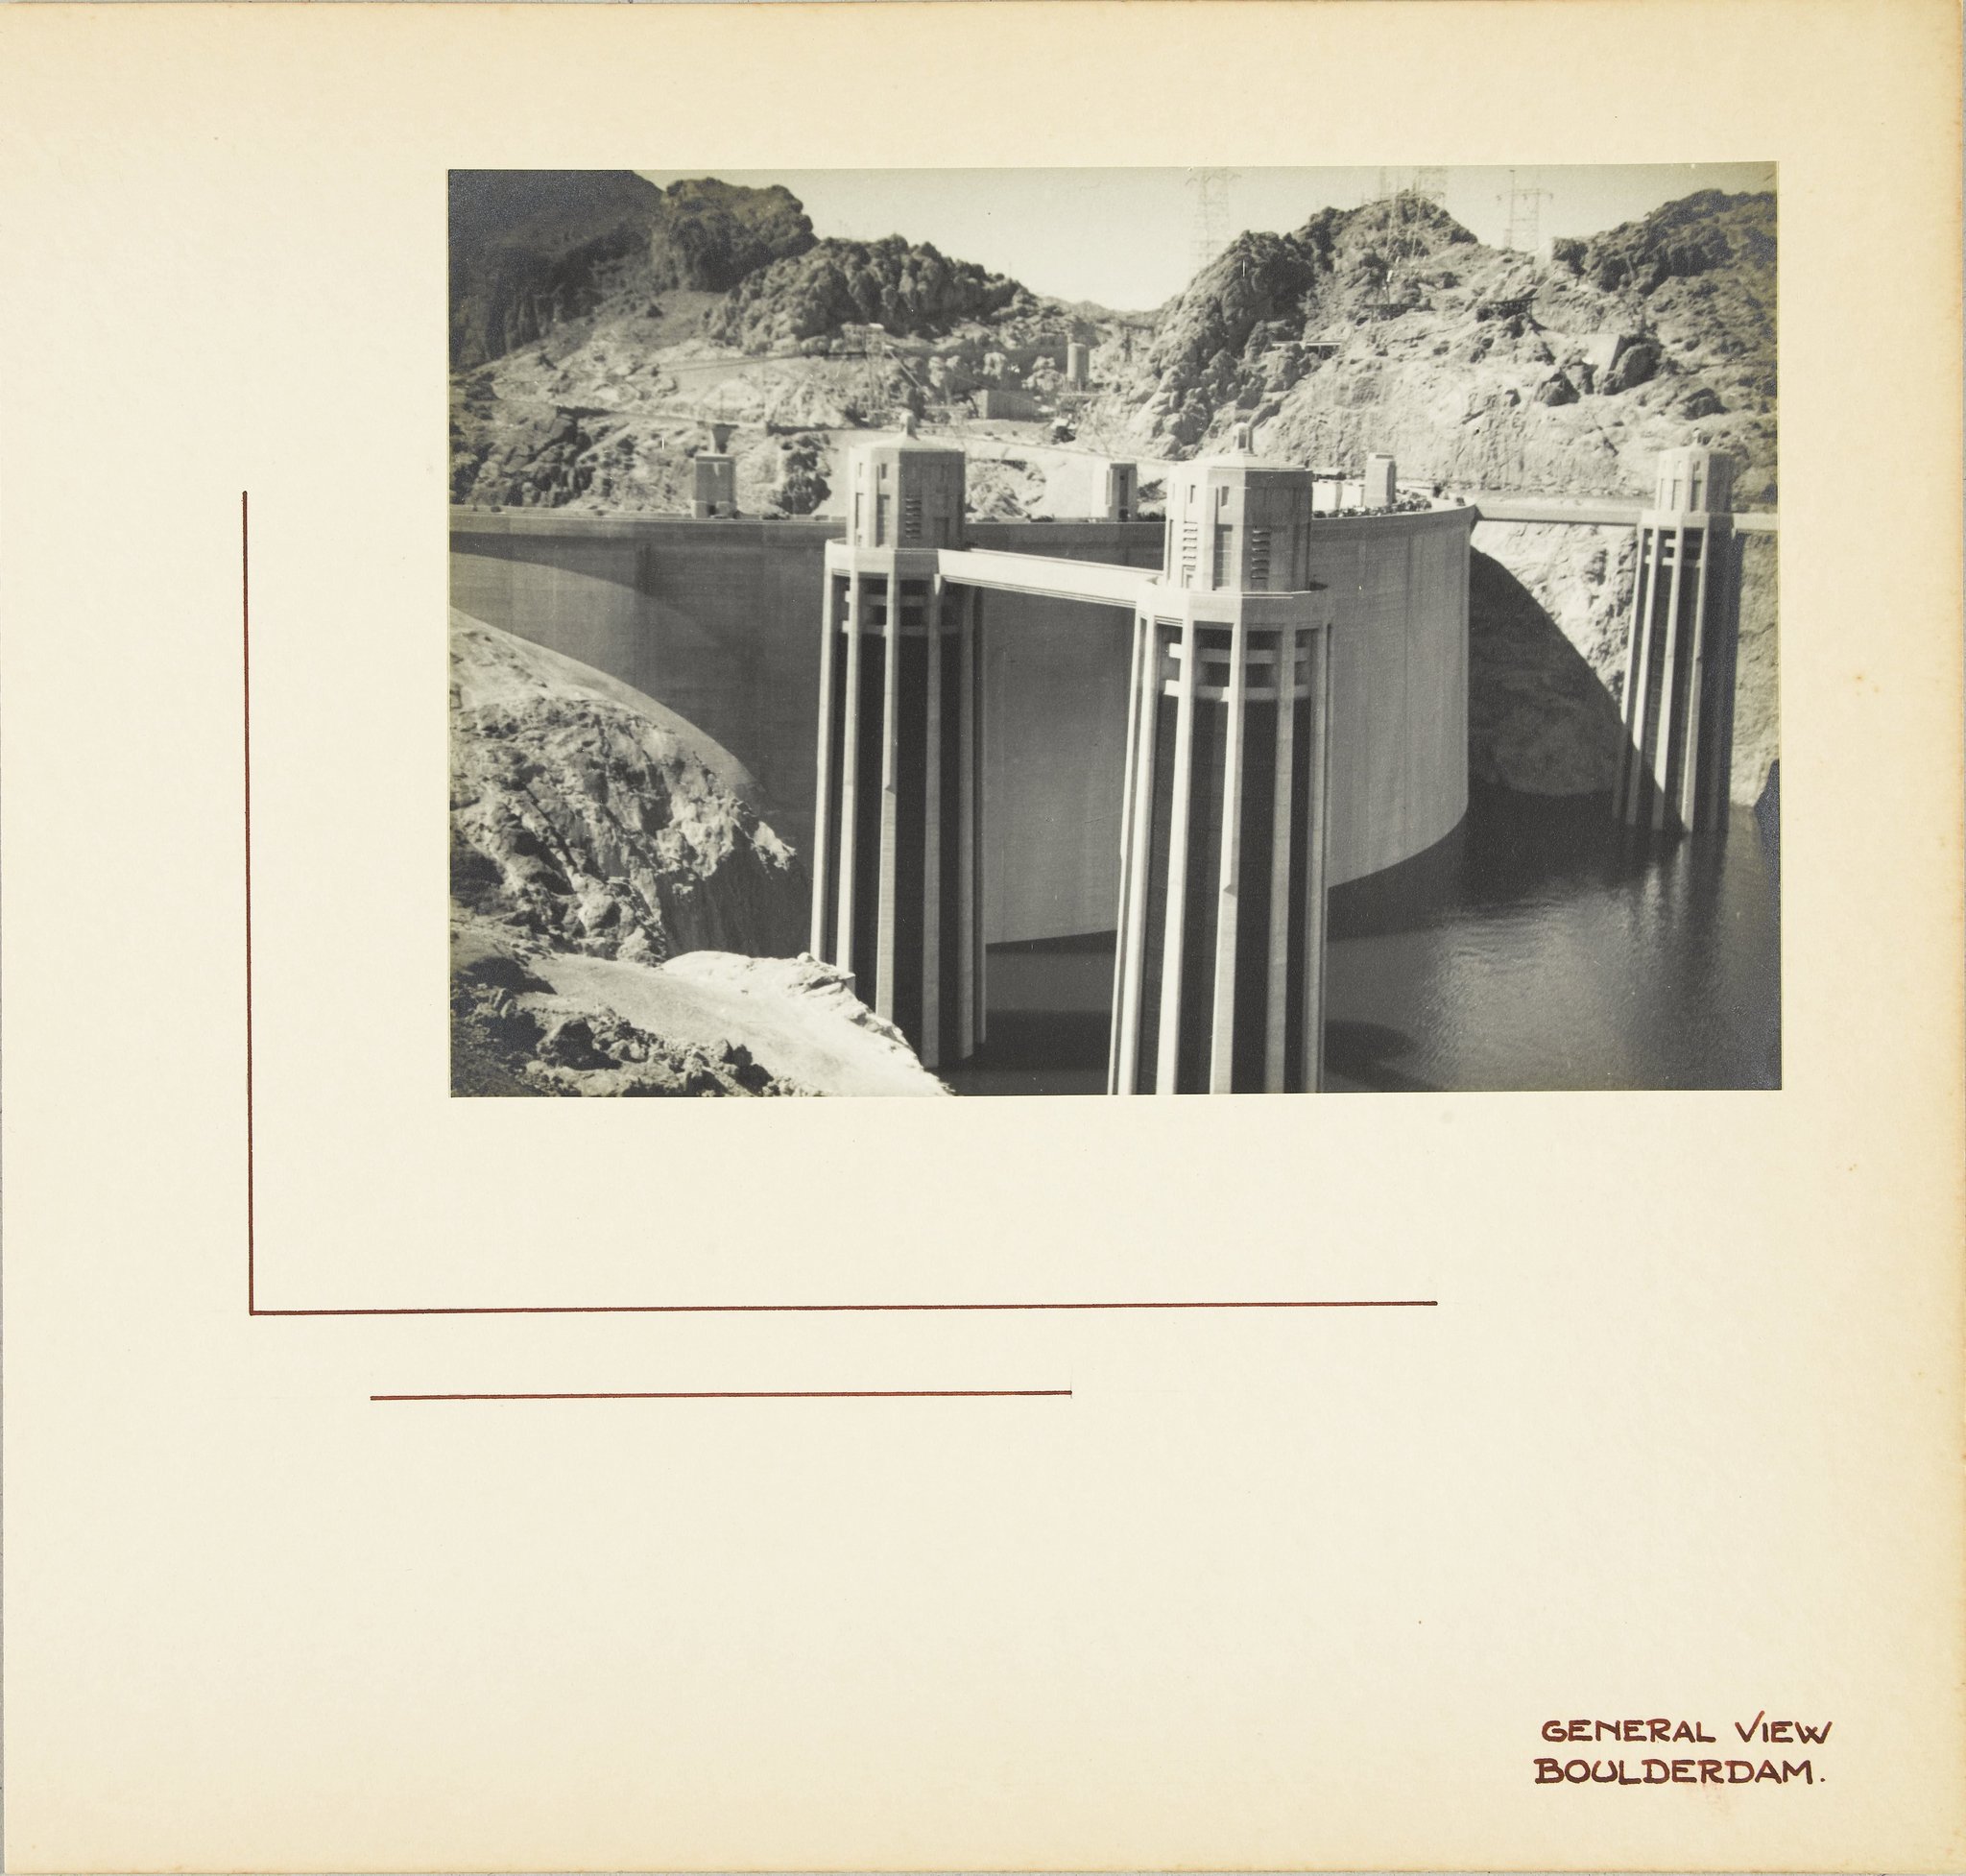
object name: photograph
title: General view Boulder dam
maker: wouter cool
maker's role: engineer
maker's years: 1877-1947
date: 1936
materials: cardboard, paper, photographic support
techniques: gelatin silver print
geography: united states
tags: dam (in canal)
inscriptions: title: ‘GENERAL VIEW / BOULDERDAM.’